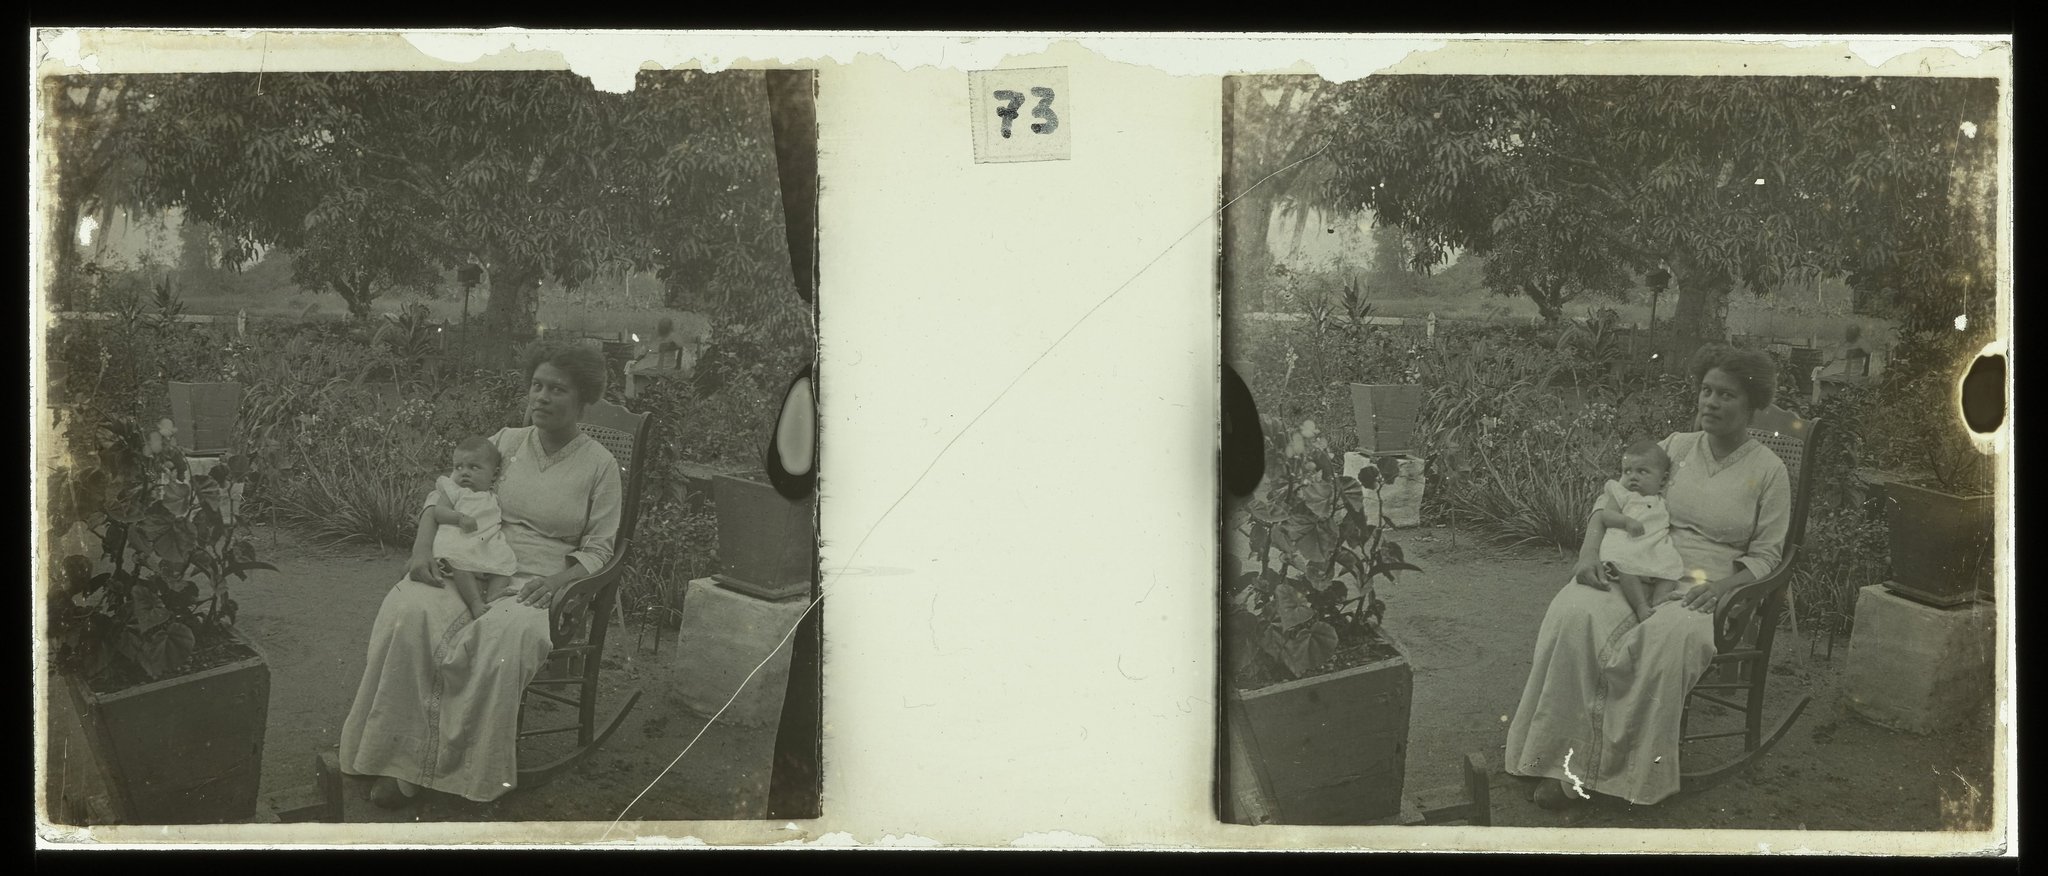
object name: stereograph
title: Lize Brouwers met zoon Gerard op de veranda van Plantage Accaribo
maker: theodoor brouwers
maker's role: amateurfotograaf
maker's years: 1874-1932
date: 1913-1914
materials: glass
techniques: photography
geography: suriname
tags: haarlem, plantation, suriname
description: In de periode 1911-1932 woonde op plantage Accaribo in Suriname de familie Brouwers van wie de foto's afkomstig zijn. Rond 1910 vond Theodoor Brouwers werk op plantage Accaribo. In 1929 werd hij eigenaar van de plantage. Op Accaribo werden in zijn tijd bananen geproduceerd en wat koffie.